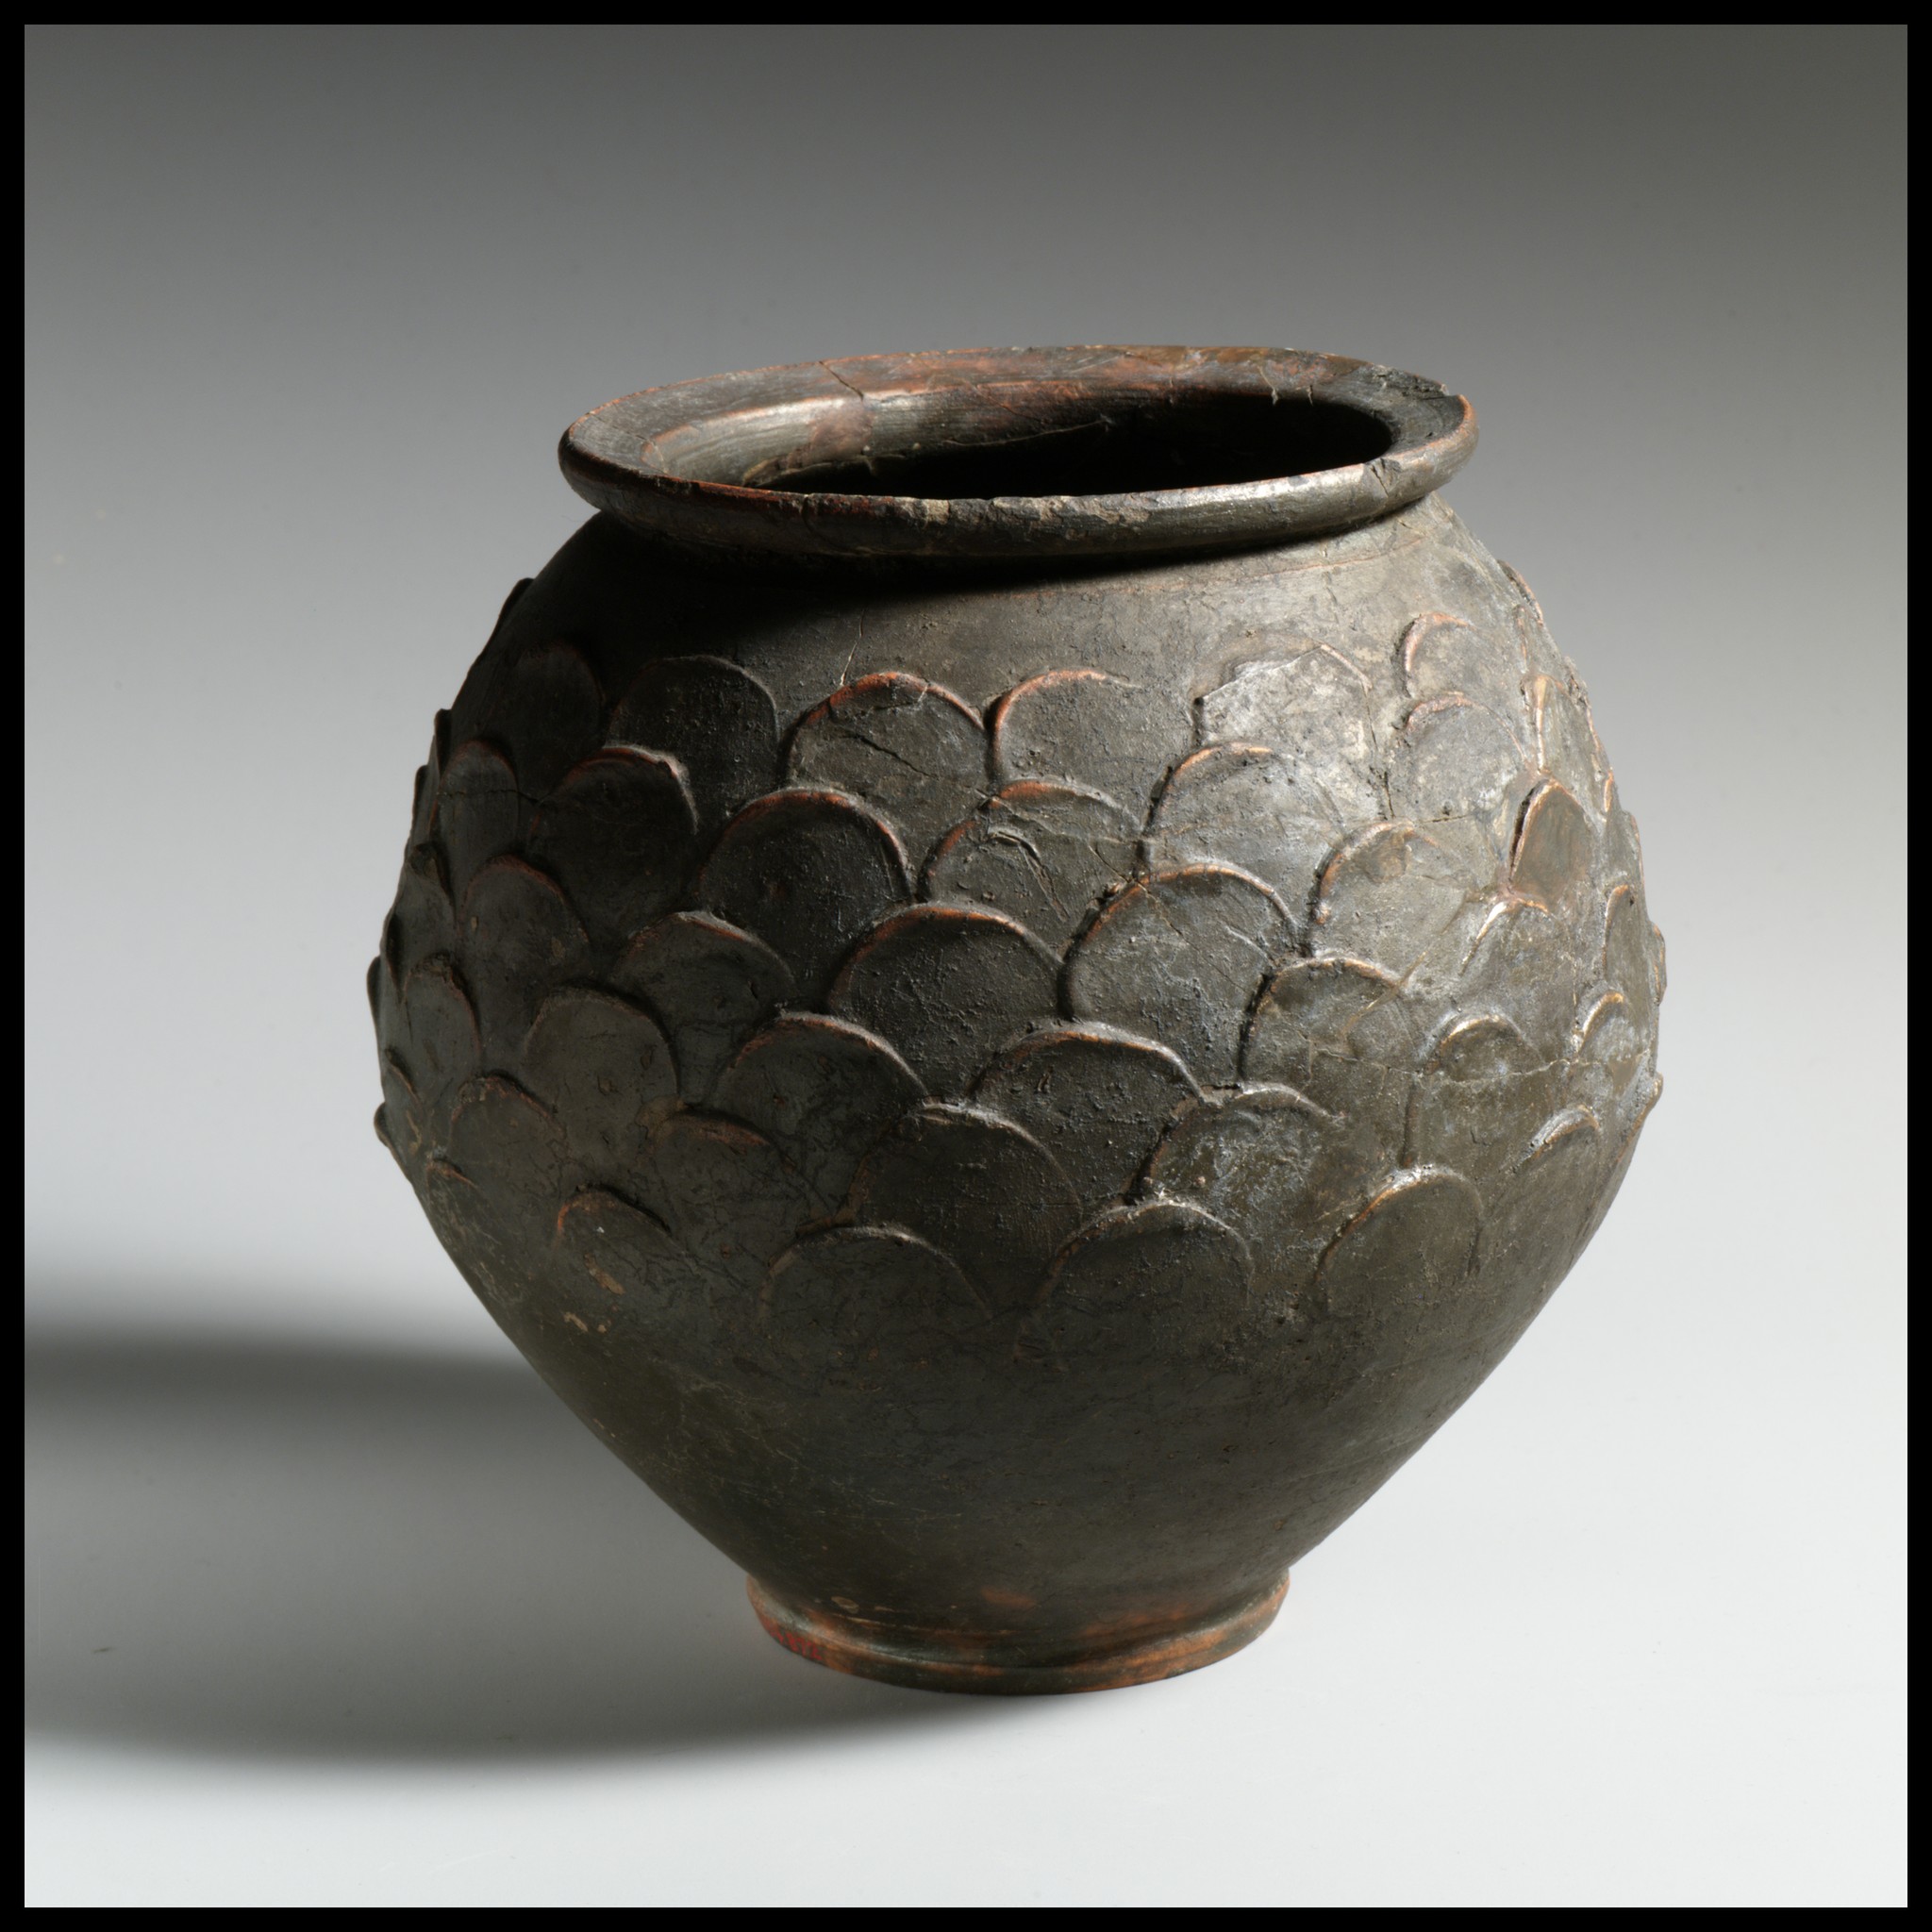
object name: bowl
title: Terracotta jar with barbotine decoration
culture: roman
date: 101-200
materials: terracotta